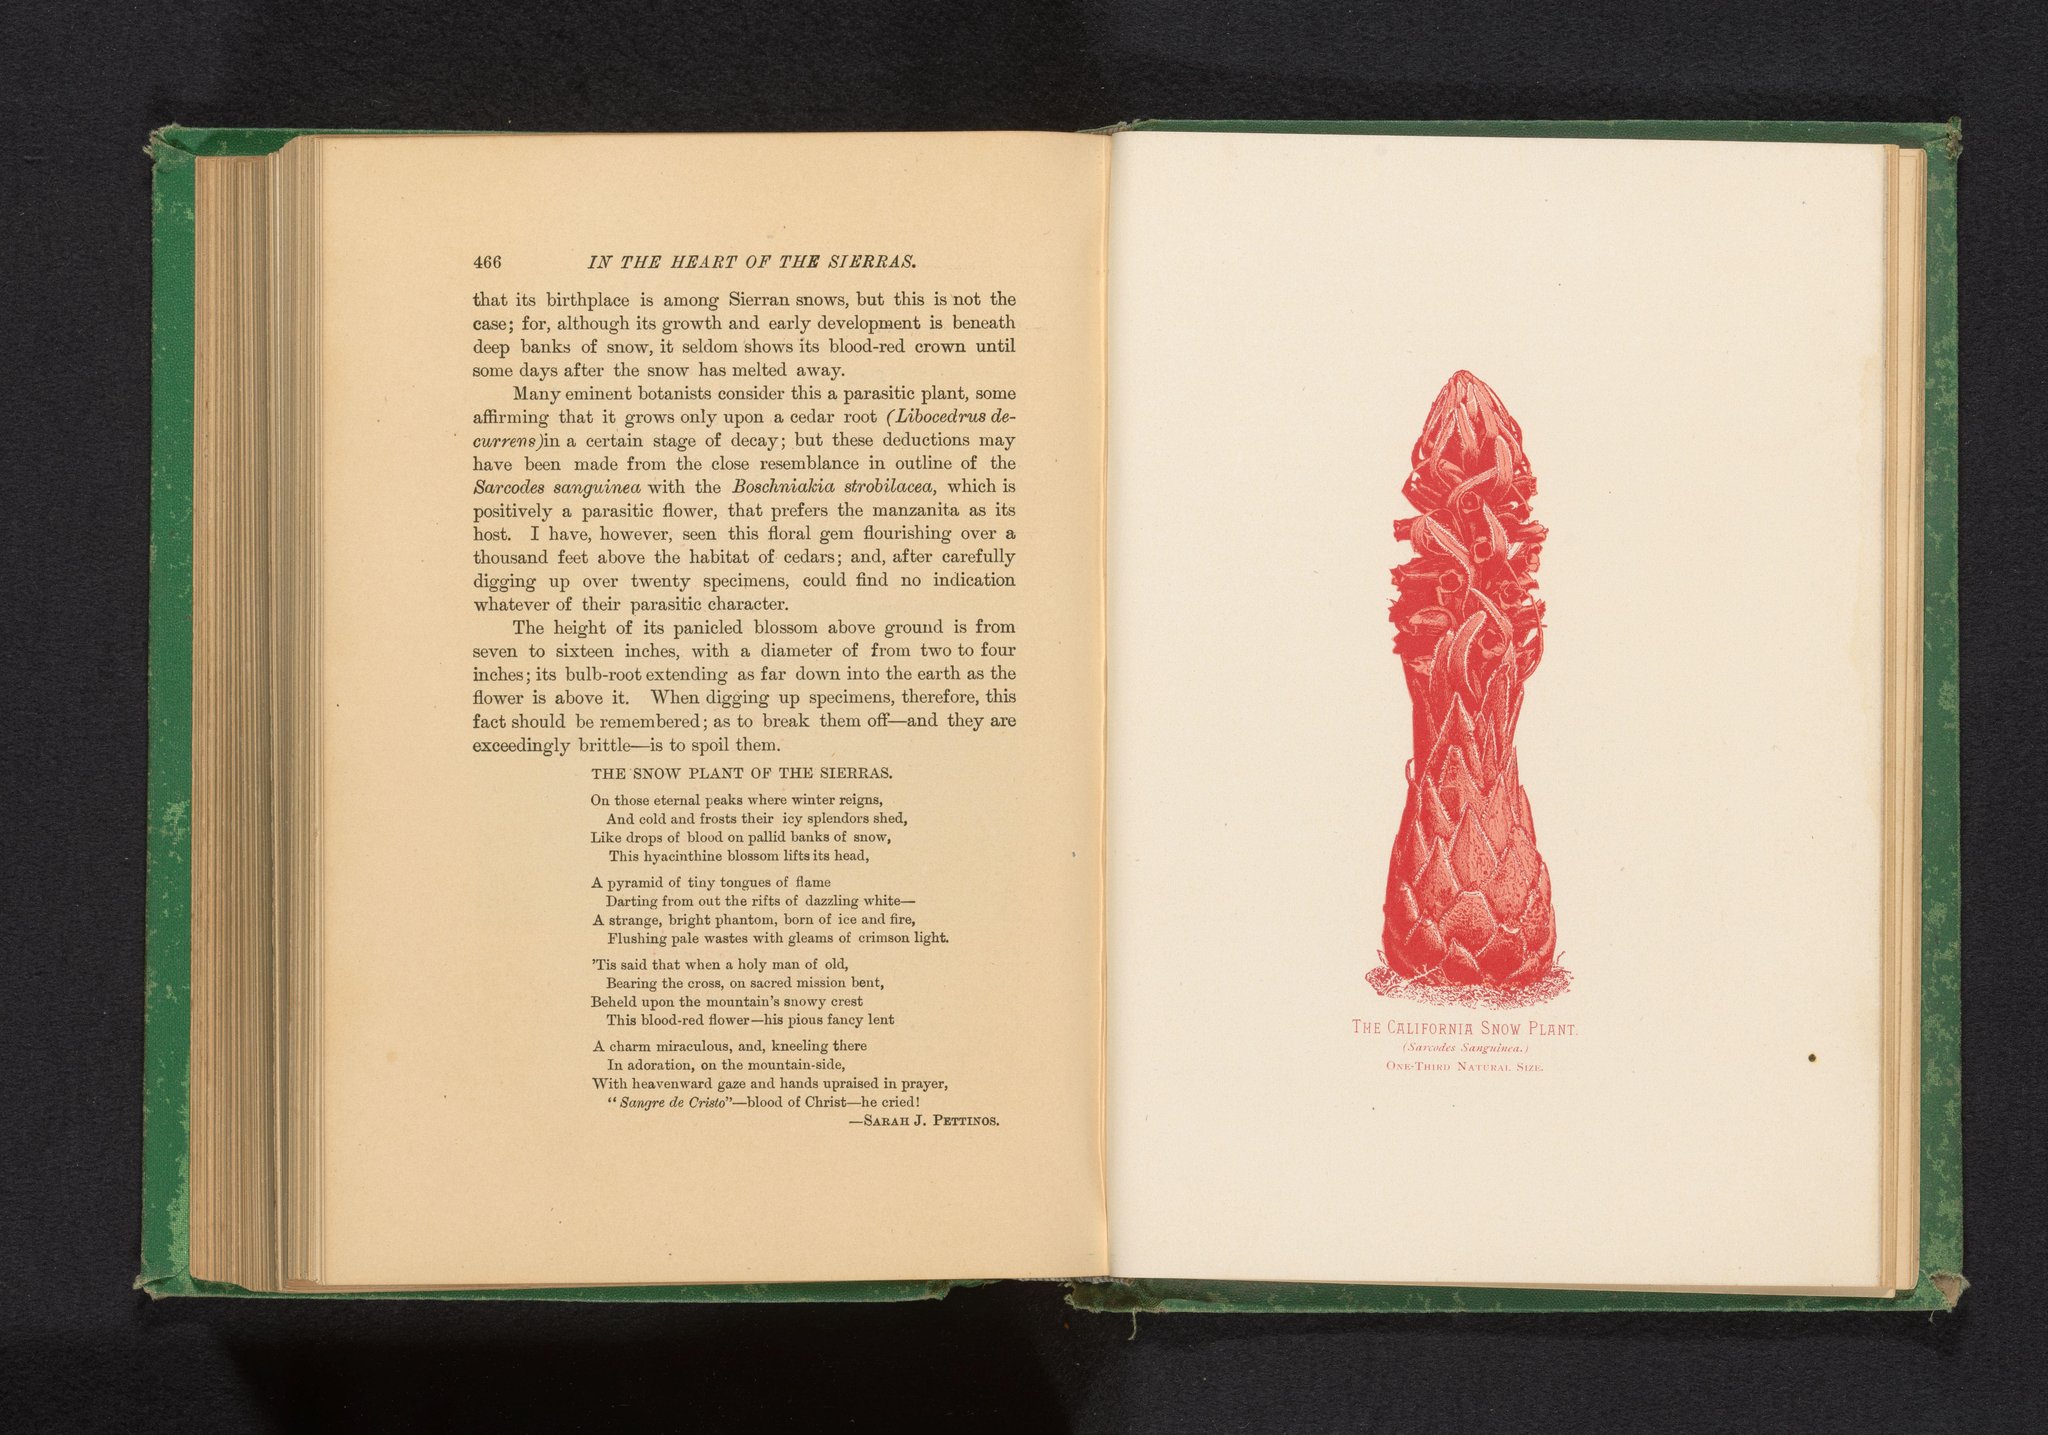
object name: photomechanical print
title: The California Snow Plant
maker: Anonymous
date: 1881-1886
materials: paper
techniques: printing block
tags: plants and herbs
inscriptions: inscription: ‘(Sarcodes Sanguinea.)/ One-Third Natural Size.’